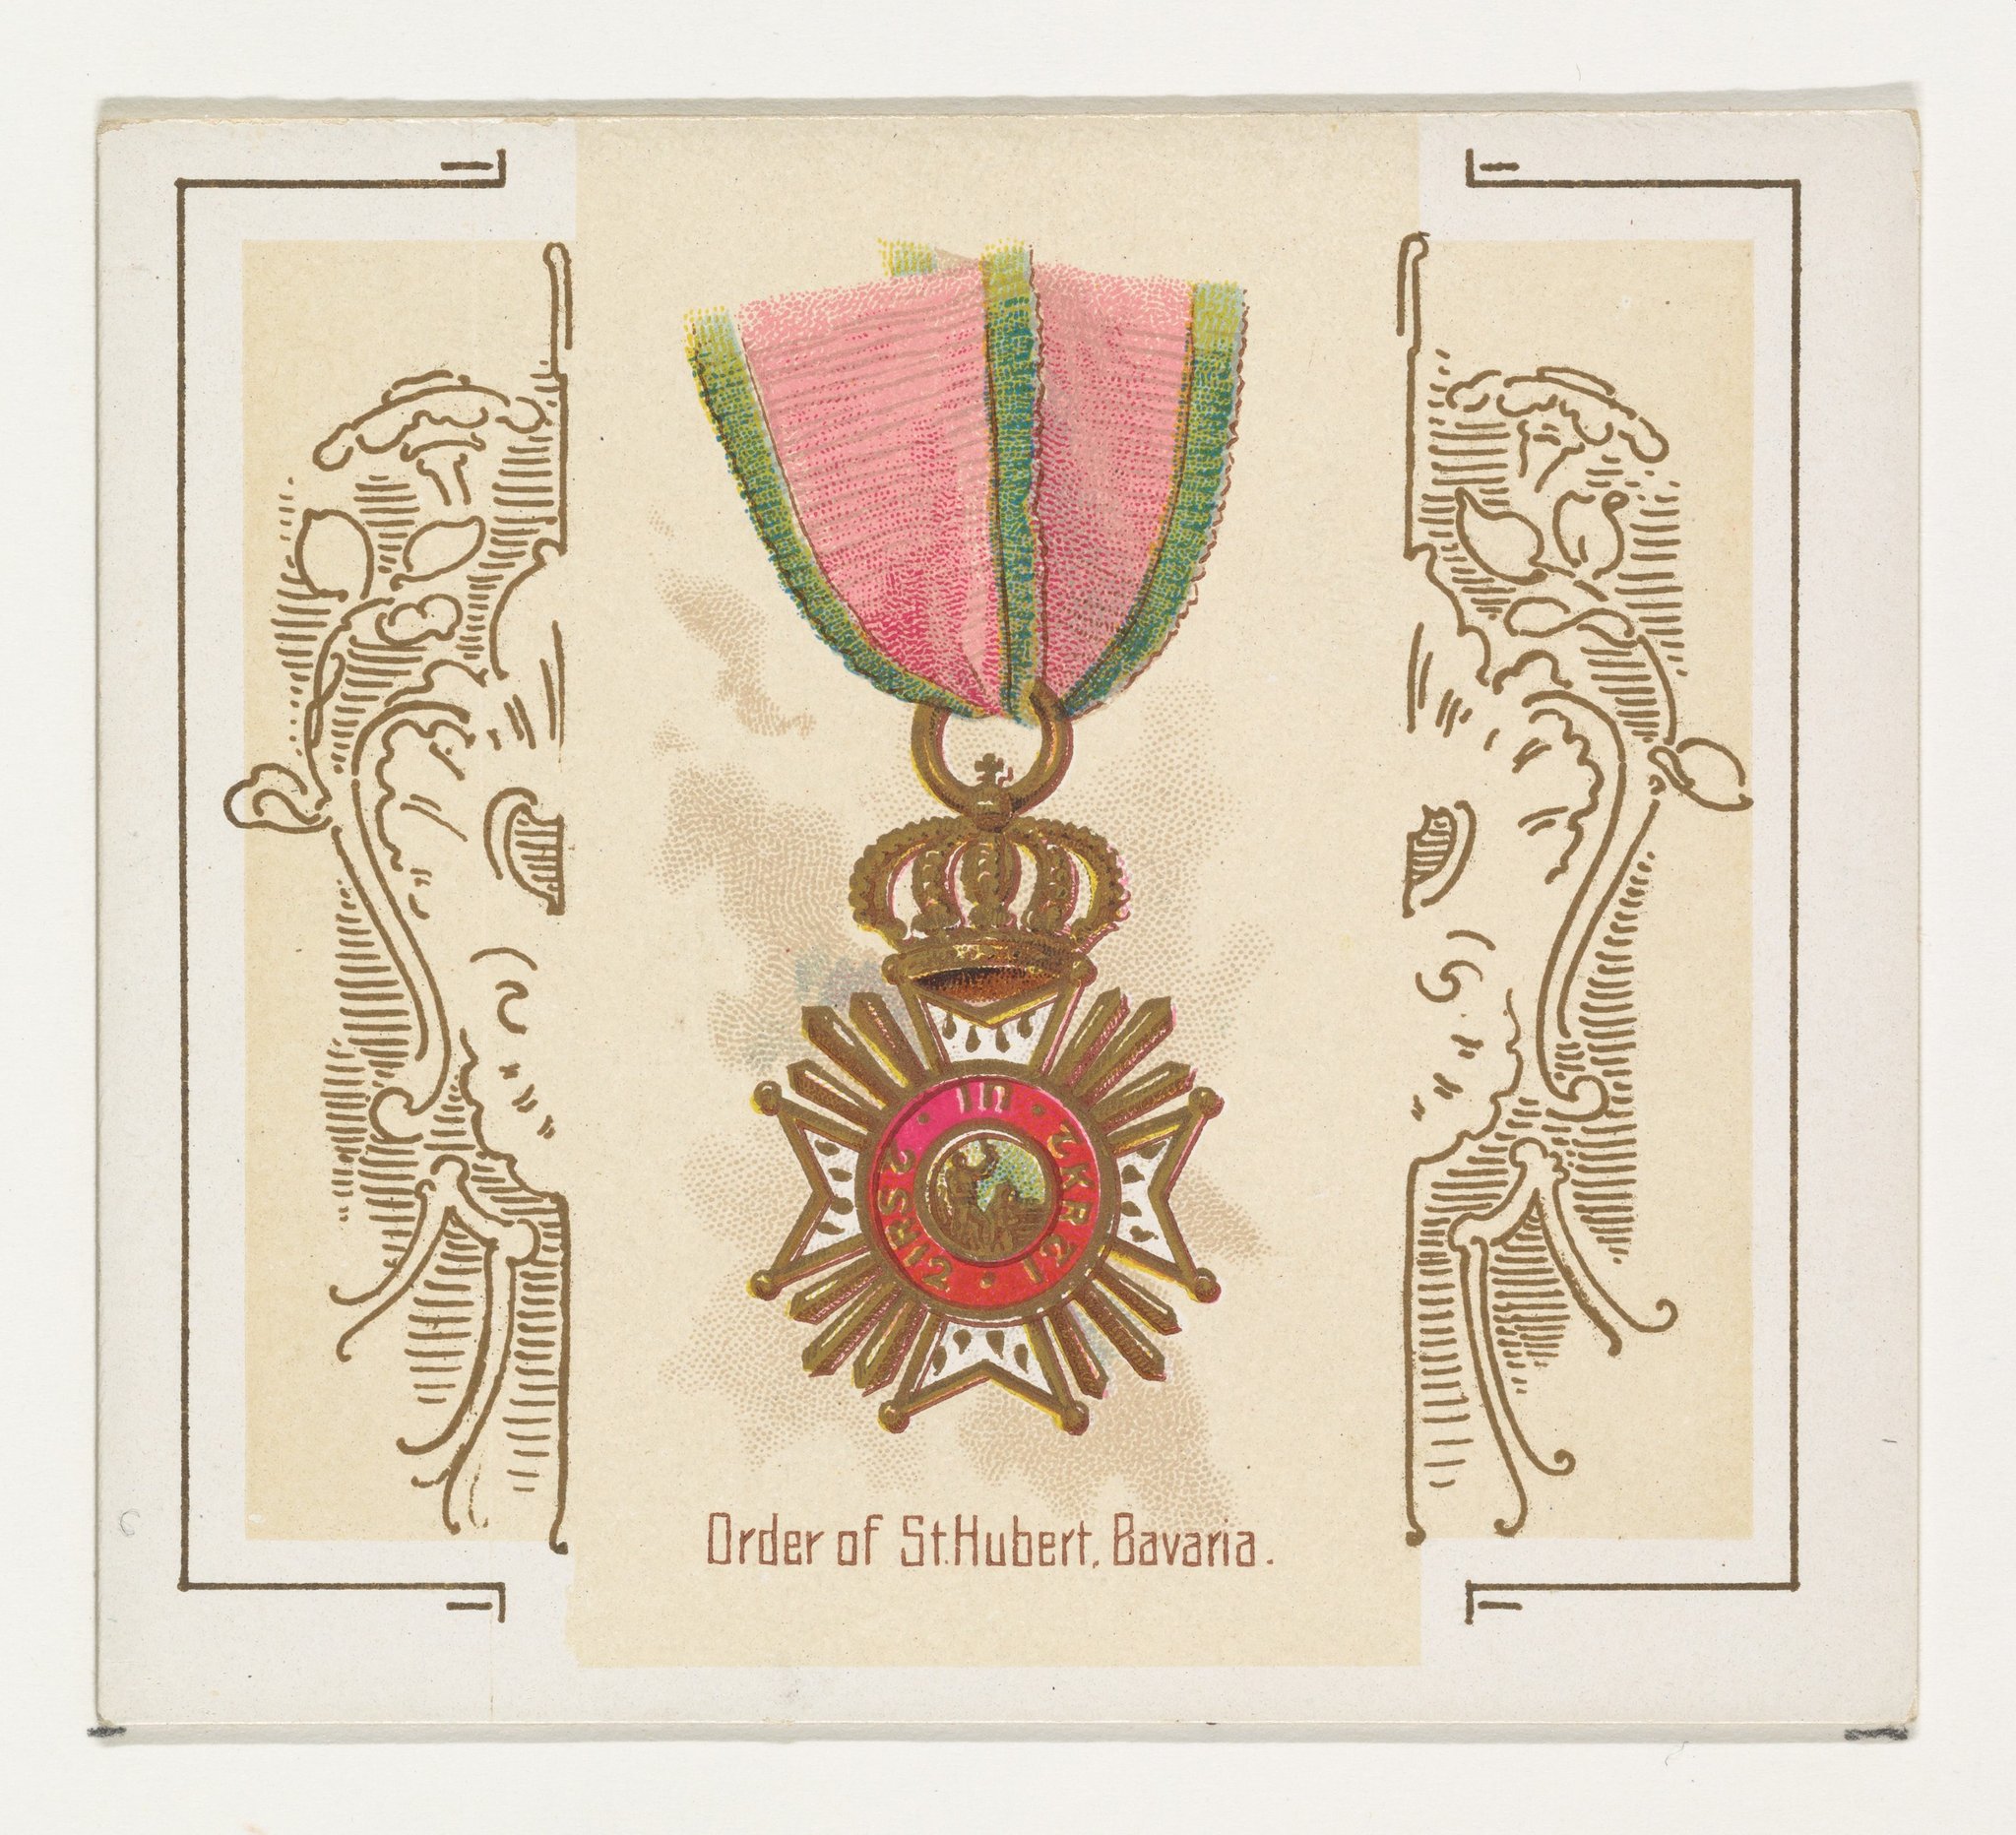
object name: print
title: Order of Saint Hubert, Bavaria, from the World's Decorations series (N44) for Allen & Ginter Cigarettes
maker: allen & ginter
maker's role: publisher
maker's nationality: american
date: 1890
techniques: color lithograph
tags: medals